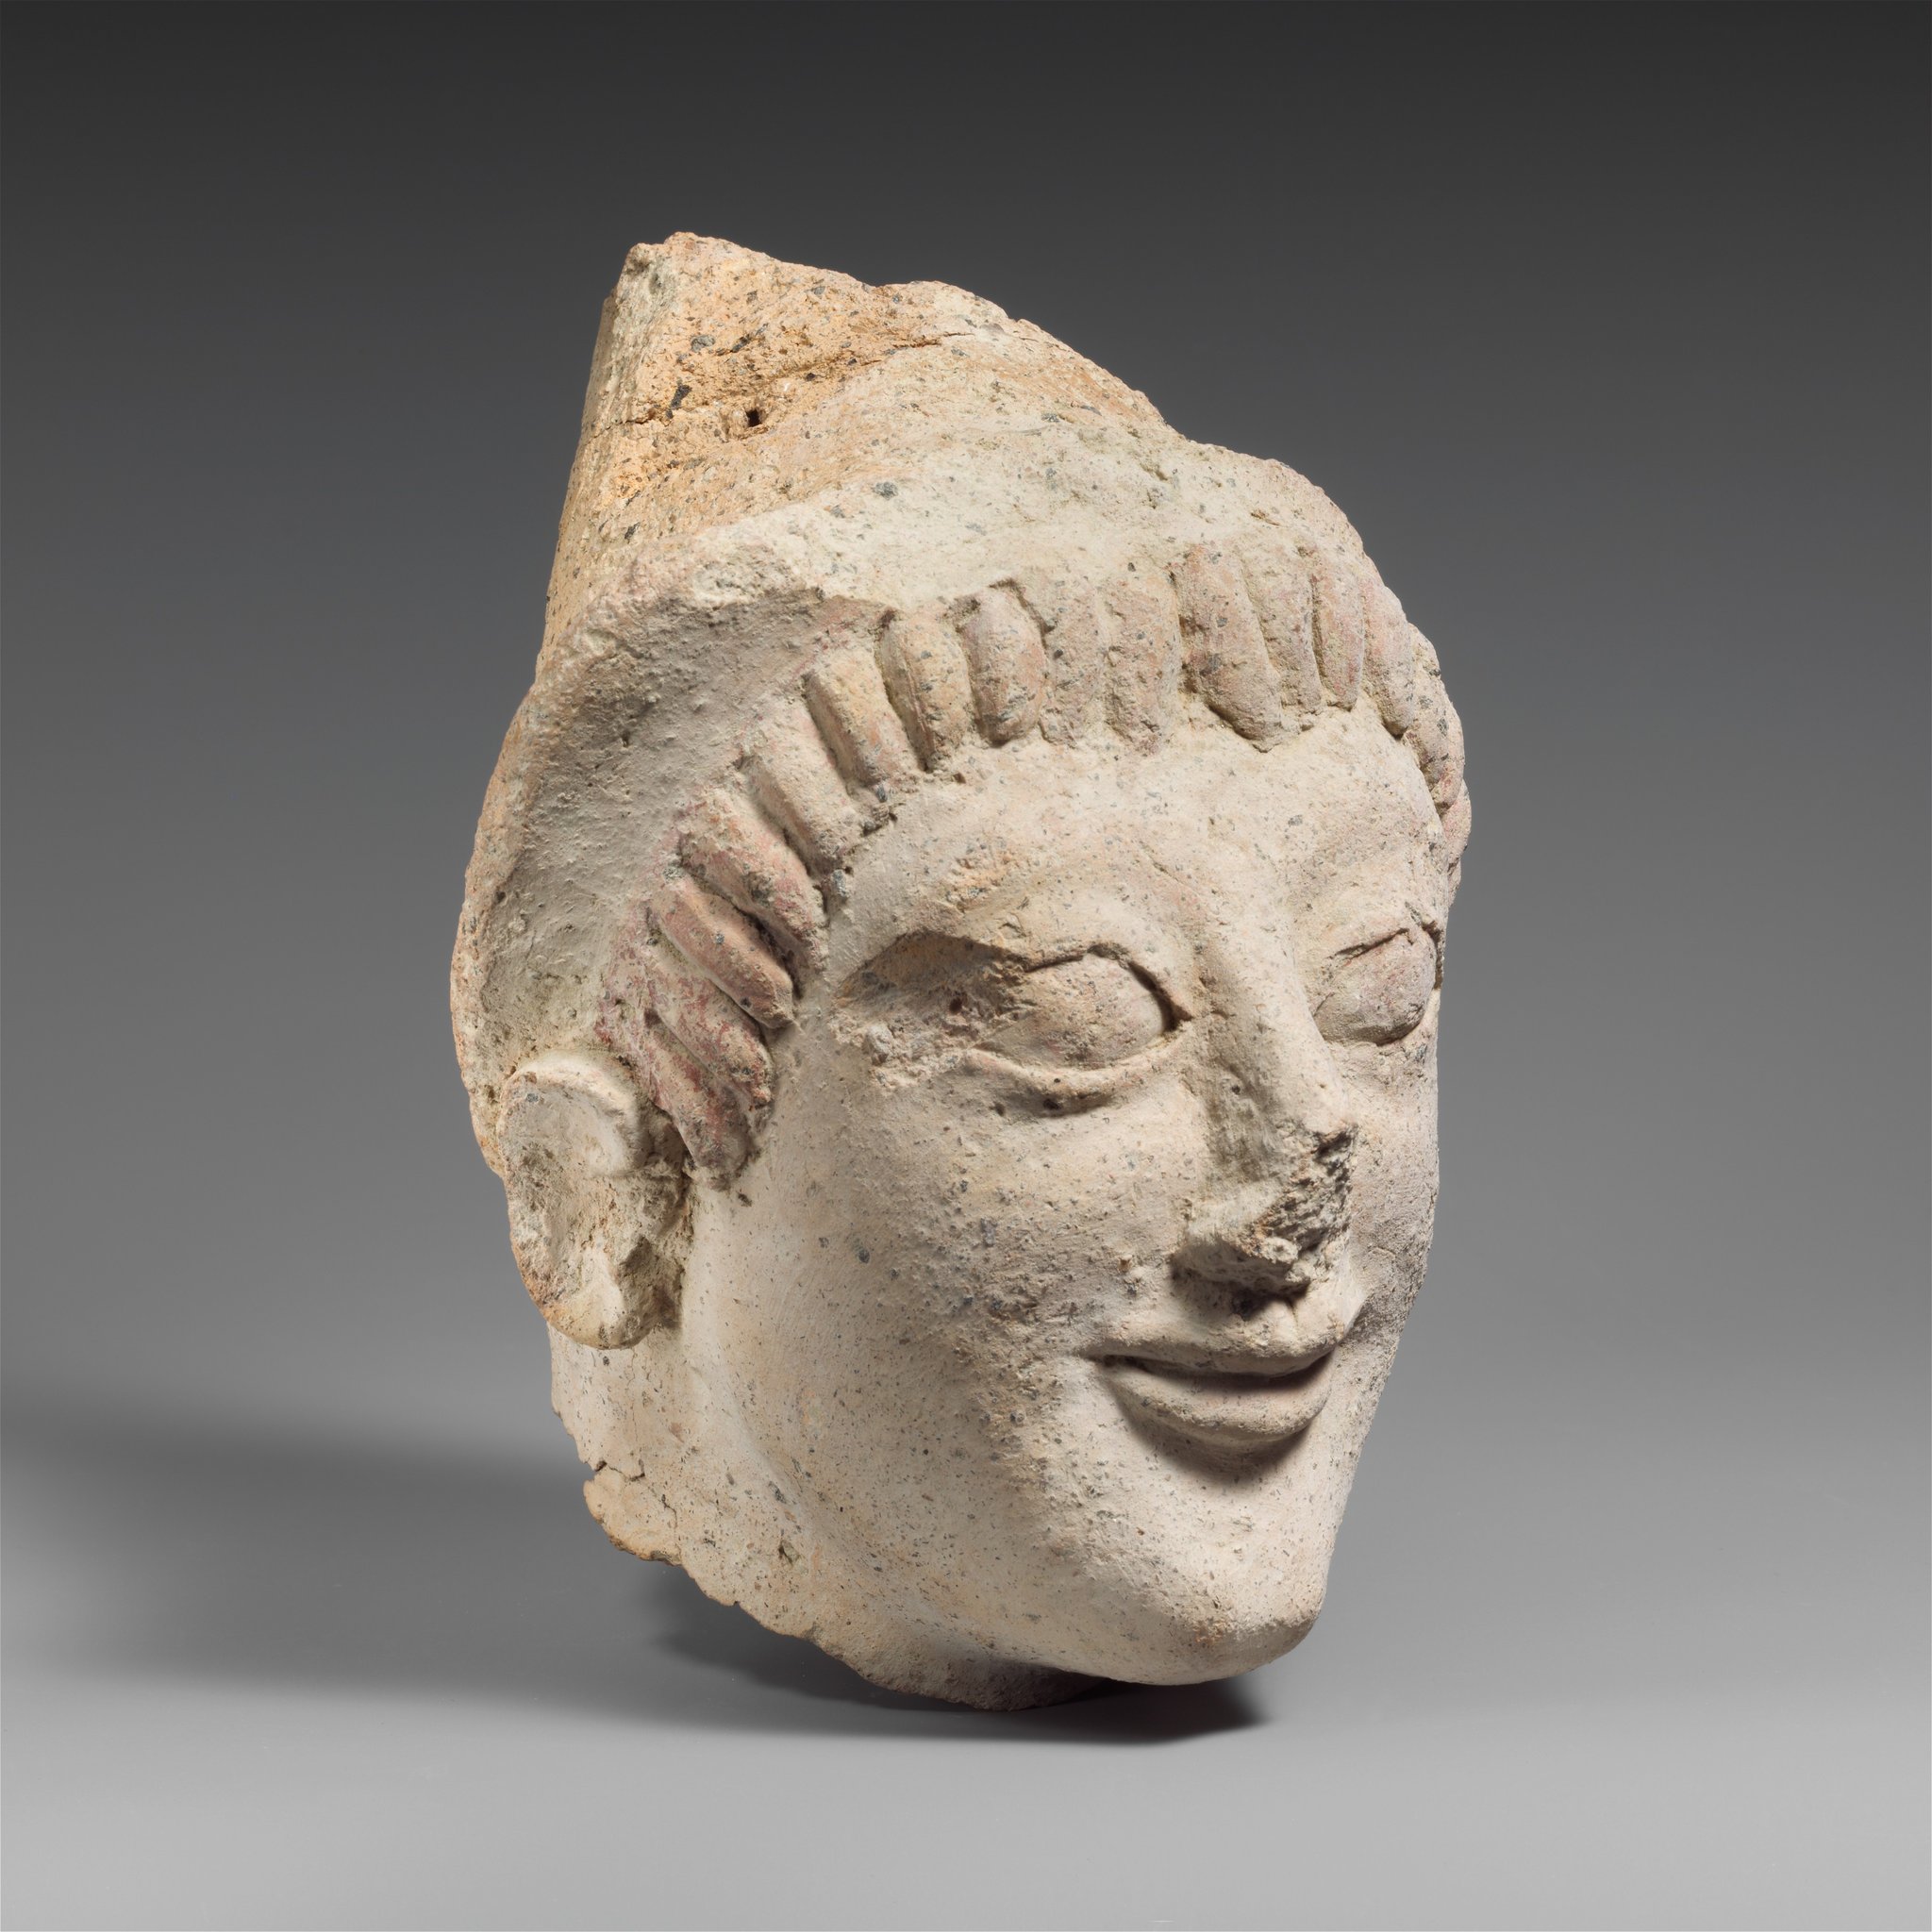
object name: head of a woman from a statue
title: Terracotta head of a woman from a statue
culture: etruscan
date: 525-500 BCE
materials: terracotta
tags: heads,women